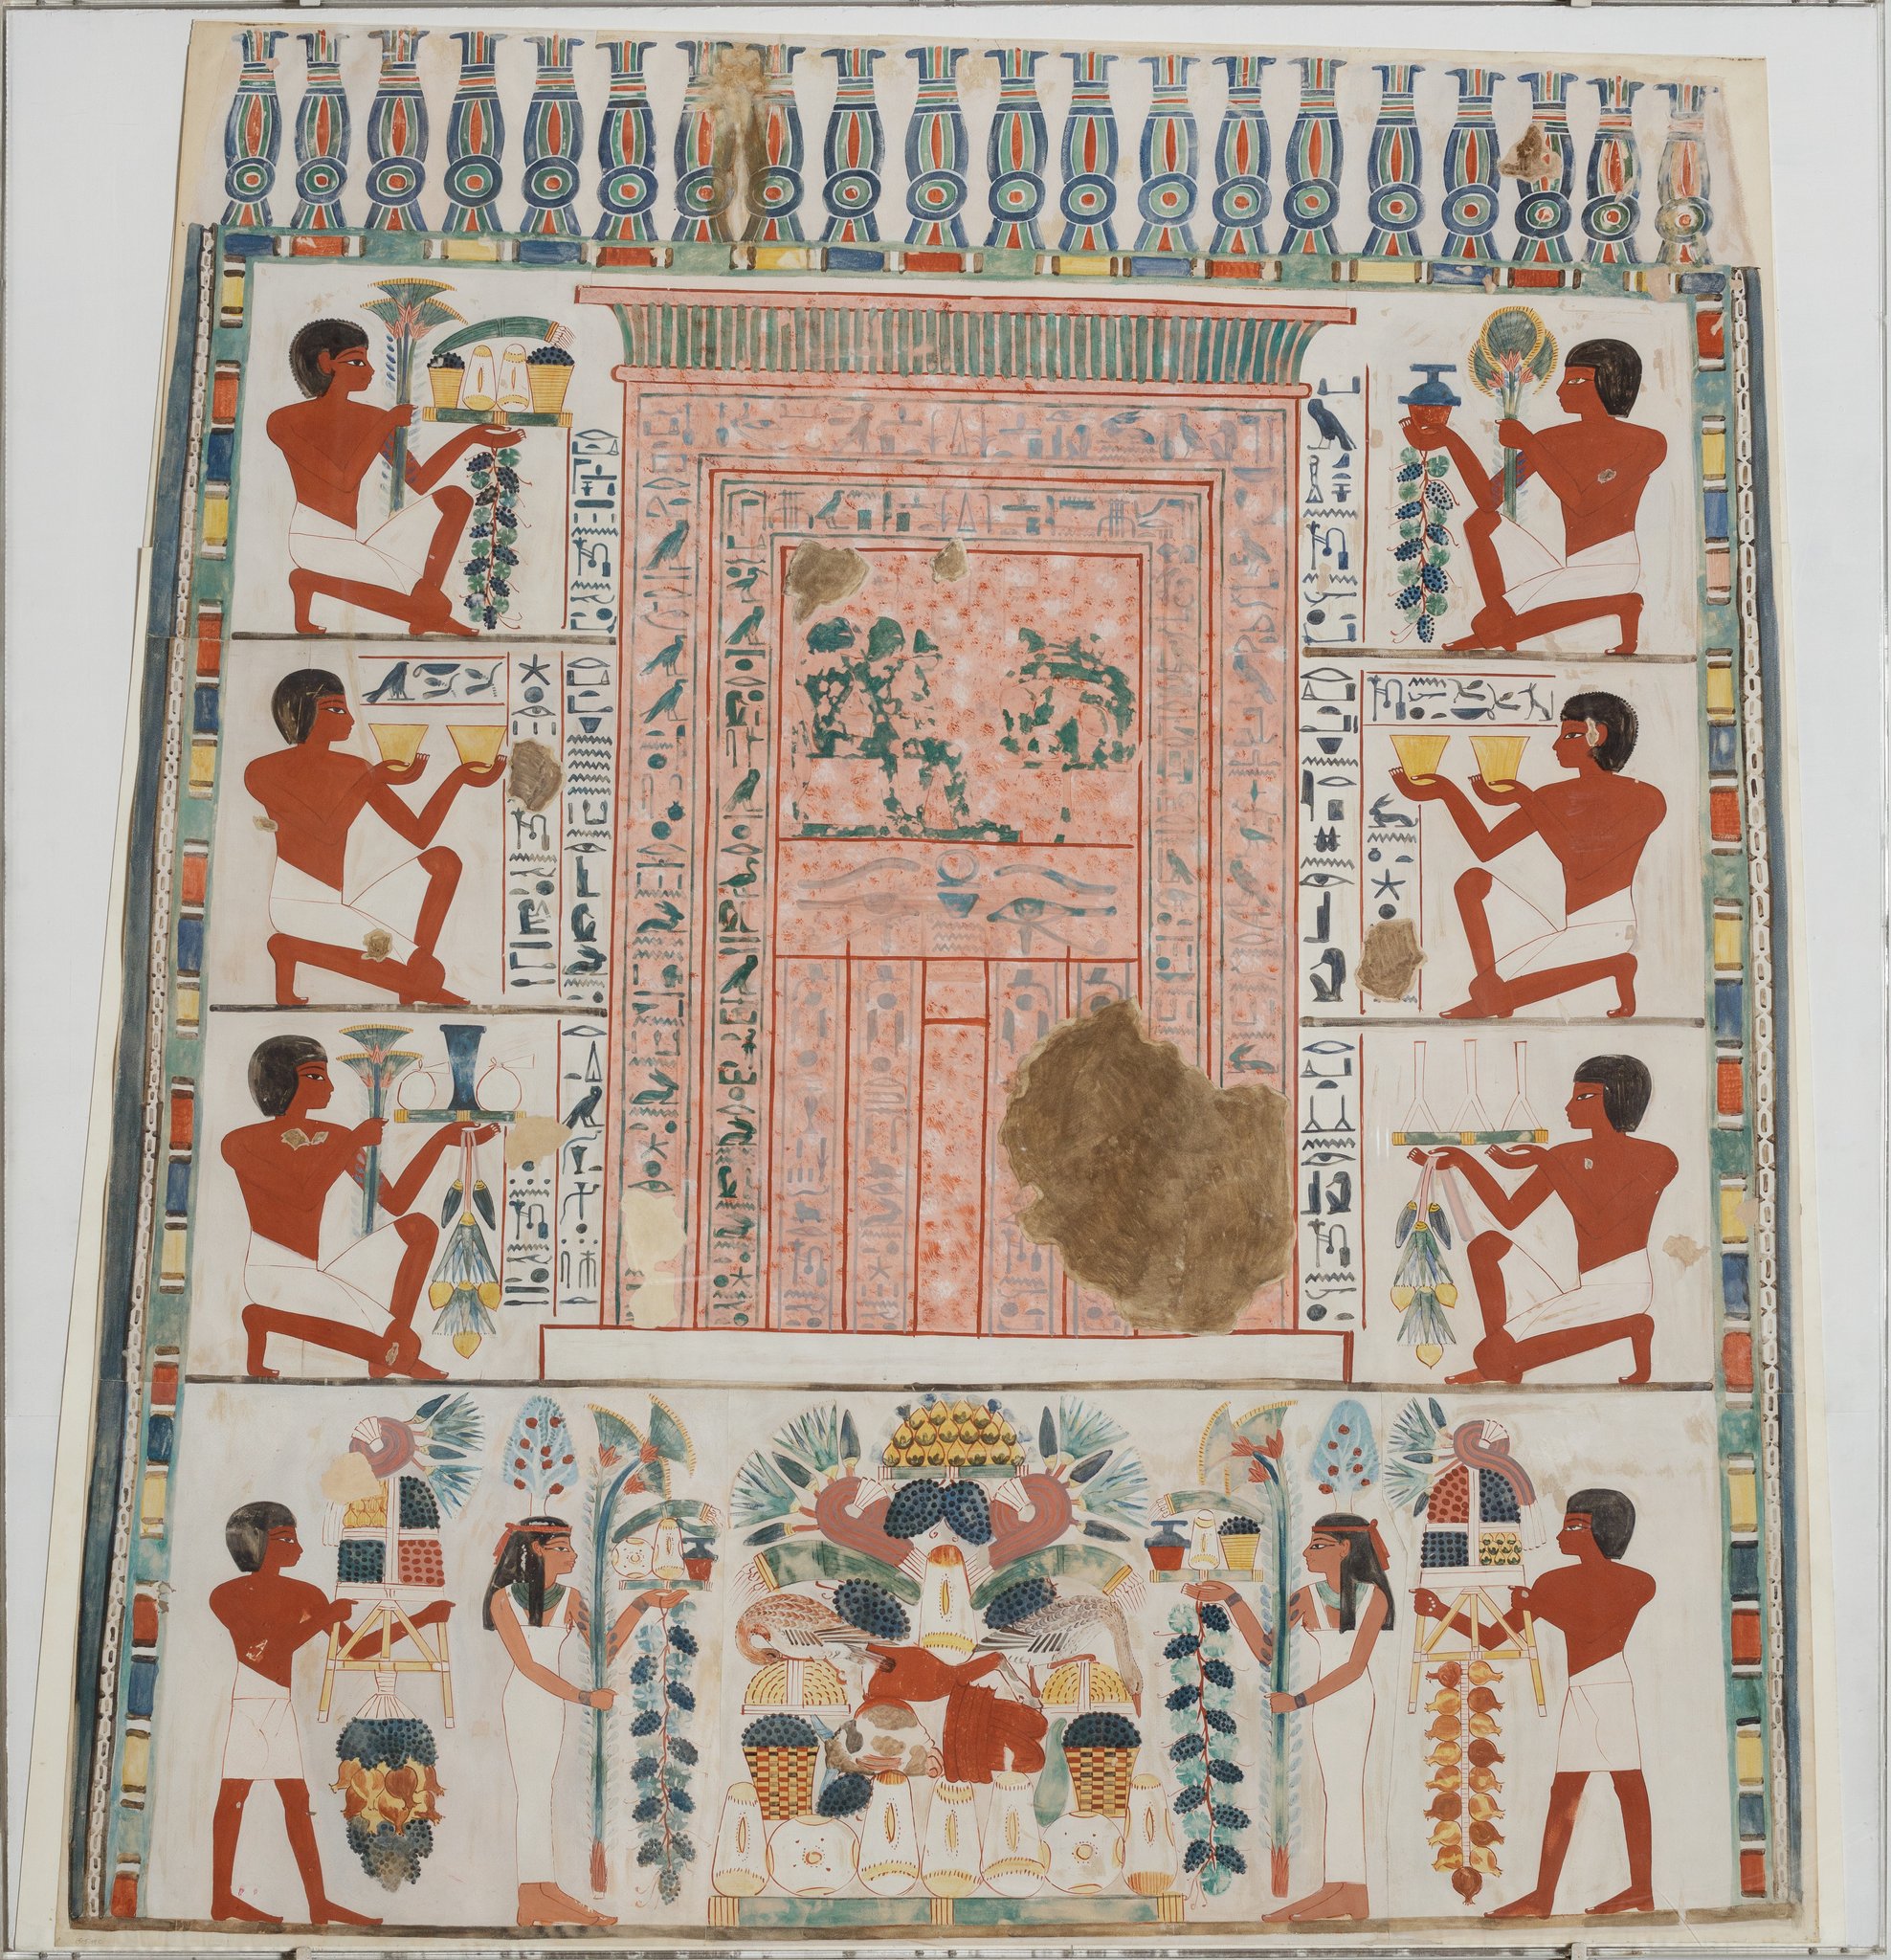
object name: facsimile, tt 52, false door, offering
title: South Wall of Nakht's Offering Chapel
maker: francis sydney unwin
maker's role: artist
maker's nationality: british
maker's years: 1885-1925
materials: paper, paint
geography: egypt